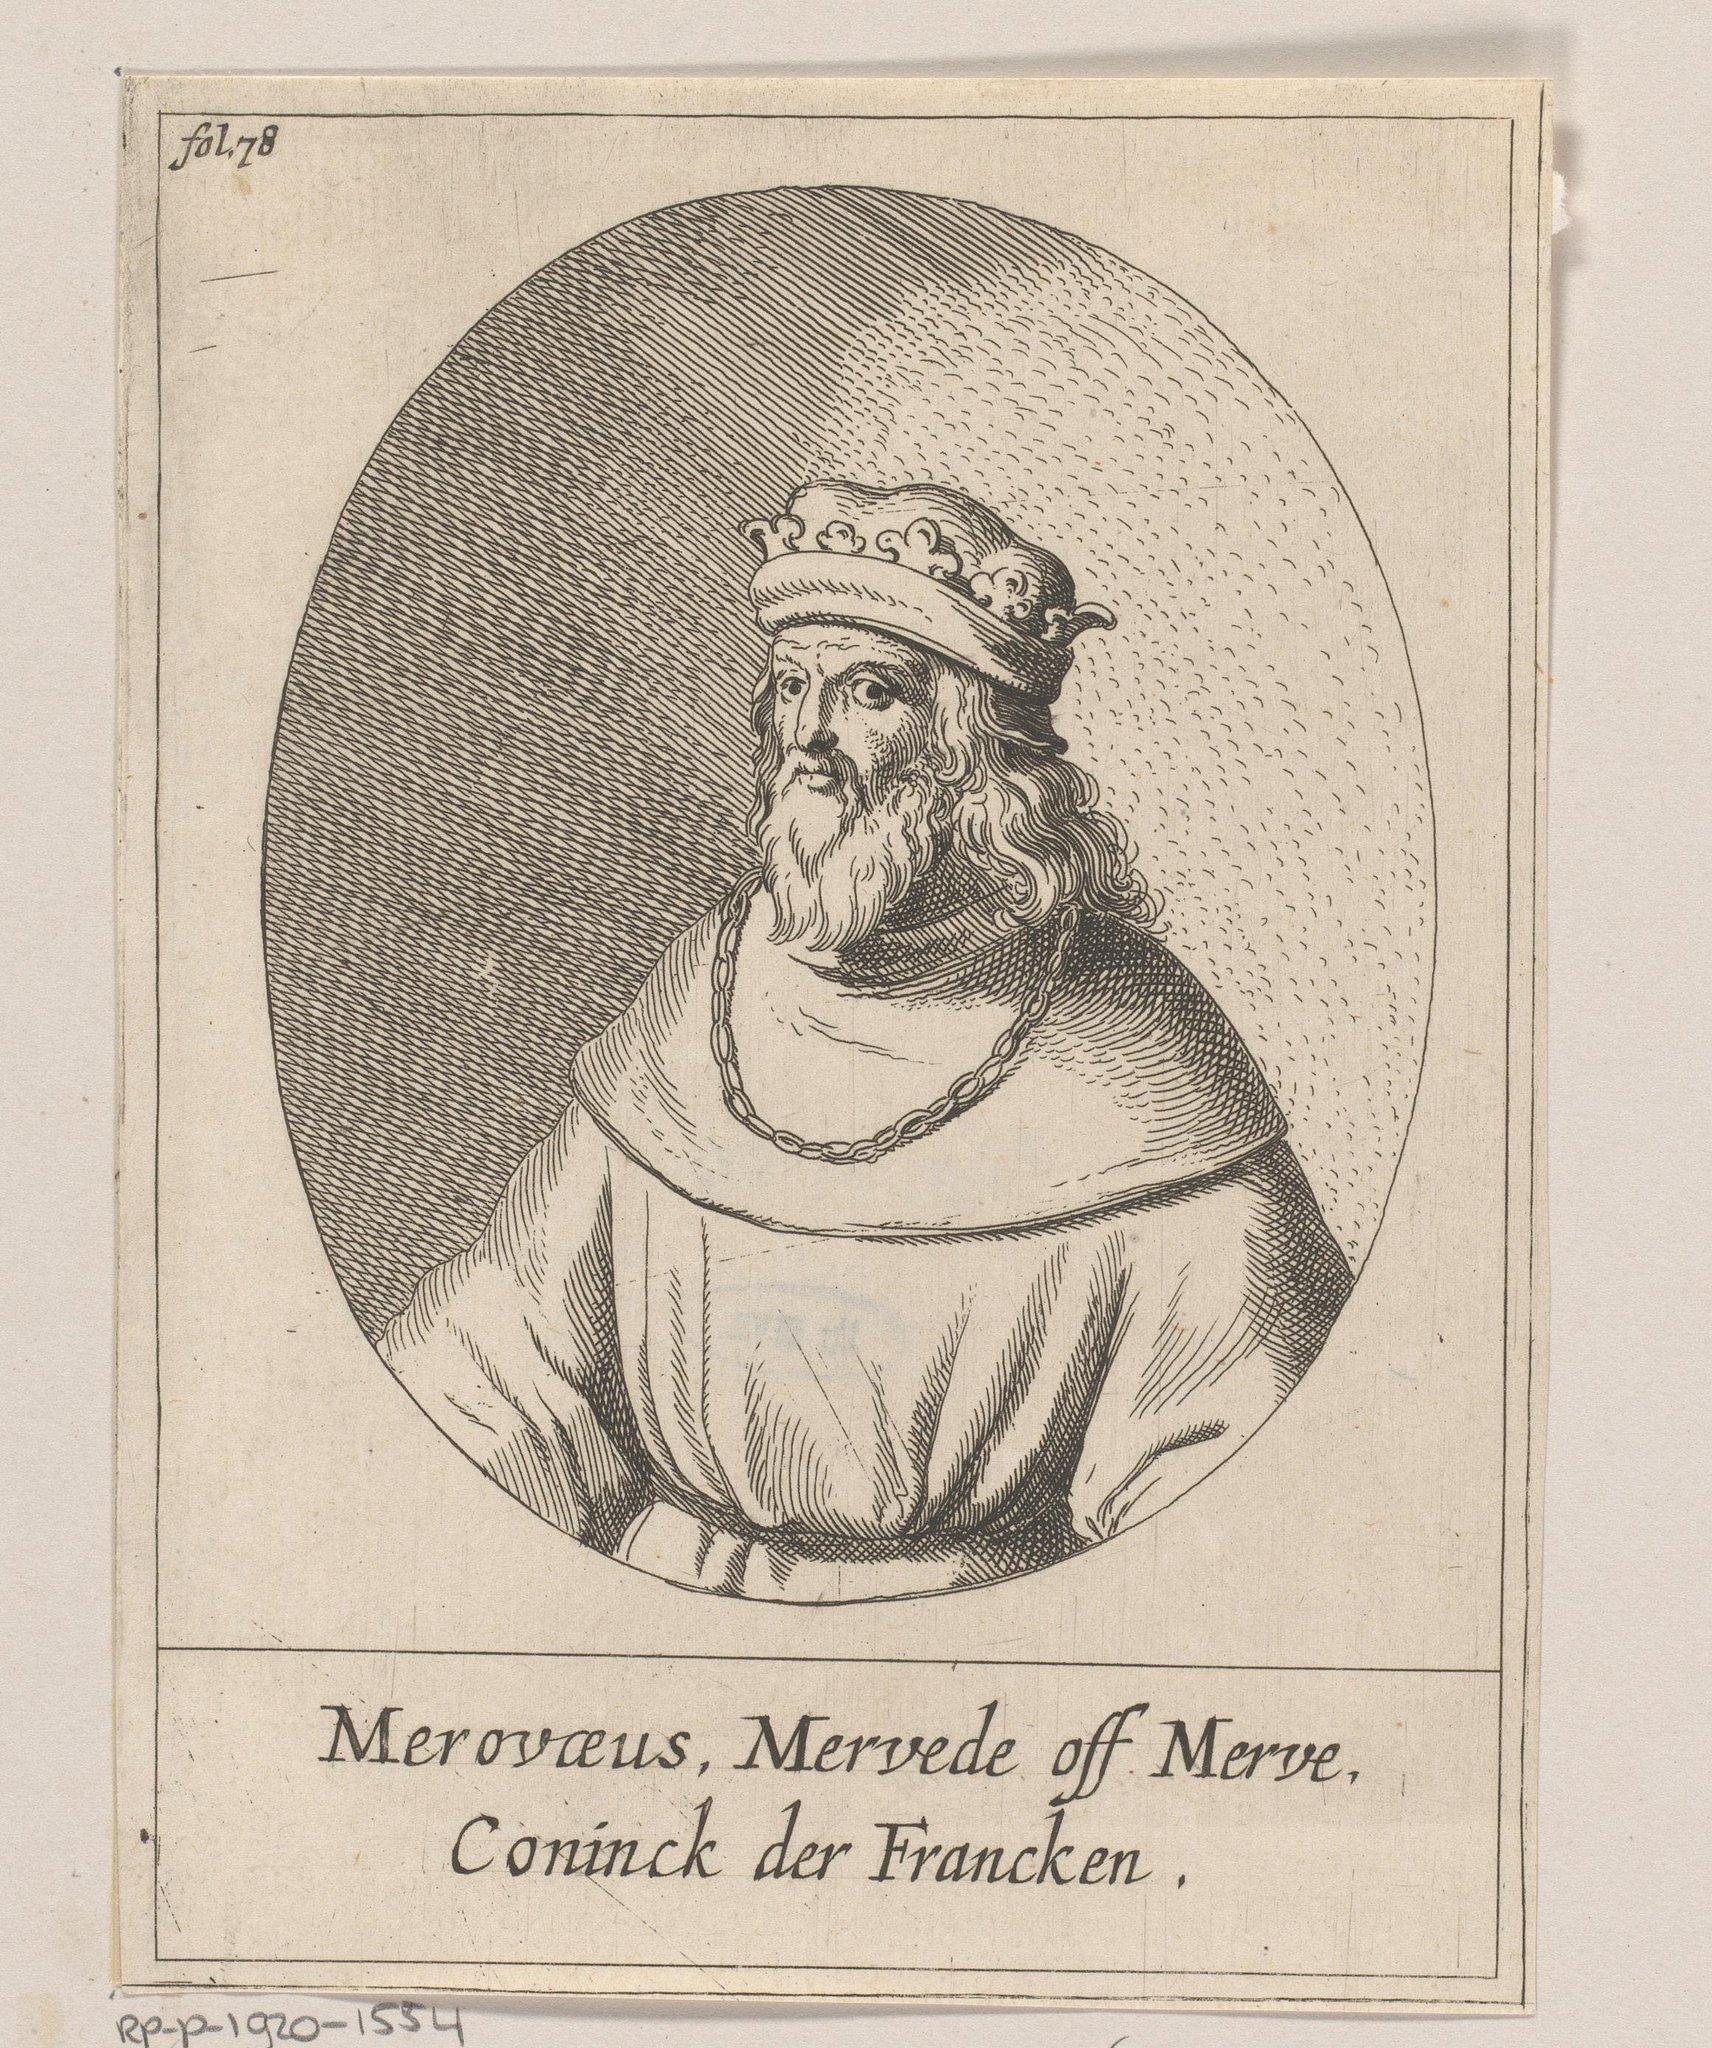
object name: print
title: Merovoeus, Mervede off Merve, Coninck der Francken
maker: Anonymous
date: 1660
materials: paper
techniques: etching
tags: historical persons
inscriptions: collector's mark: Lugt 2228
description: Prent waarschijnlijk uit: Picardt, Johan. Korte beschryvinge van eenige vergetene en verborgene antiquiteten der provintien en landen gelegen tusschen de Noord-zee, de Yssel, Emse en Lippe (...). Amsterdam: Tymon Houthaak, 1660., p. 78.